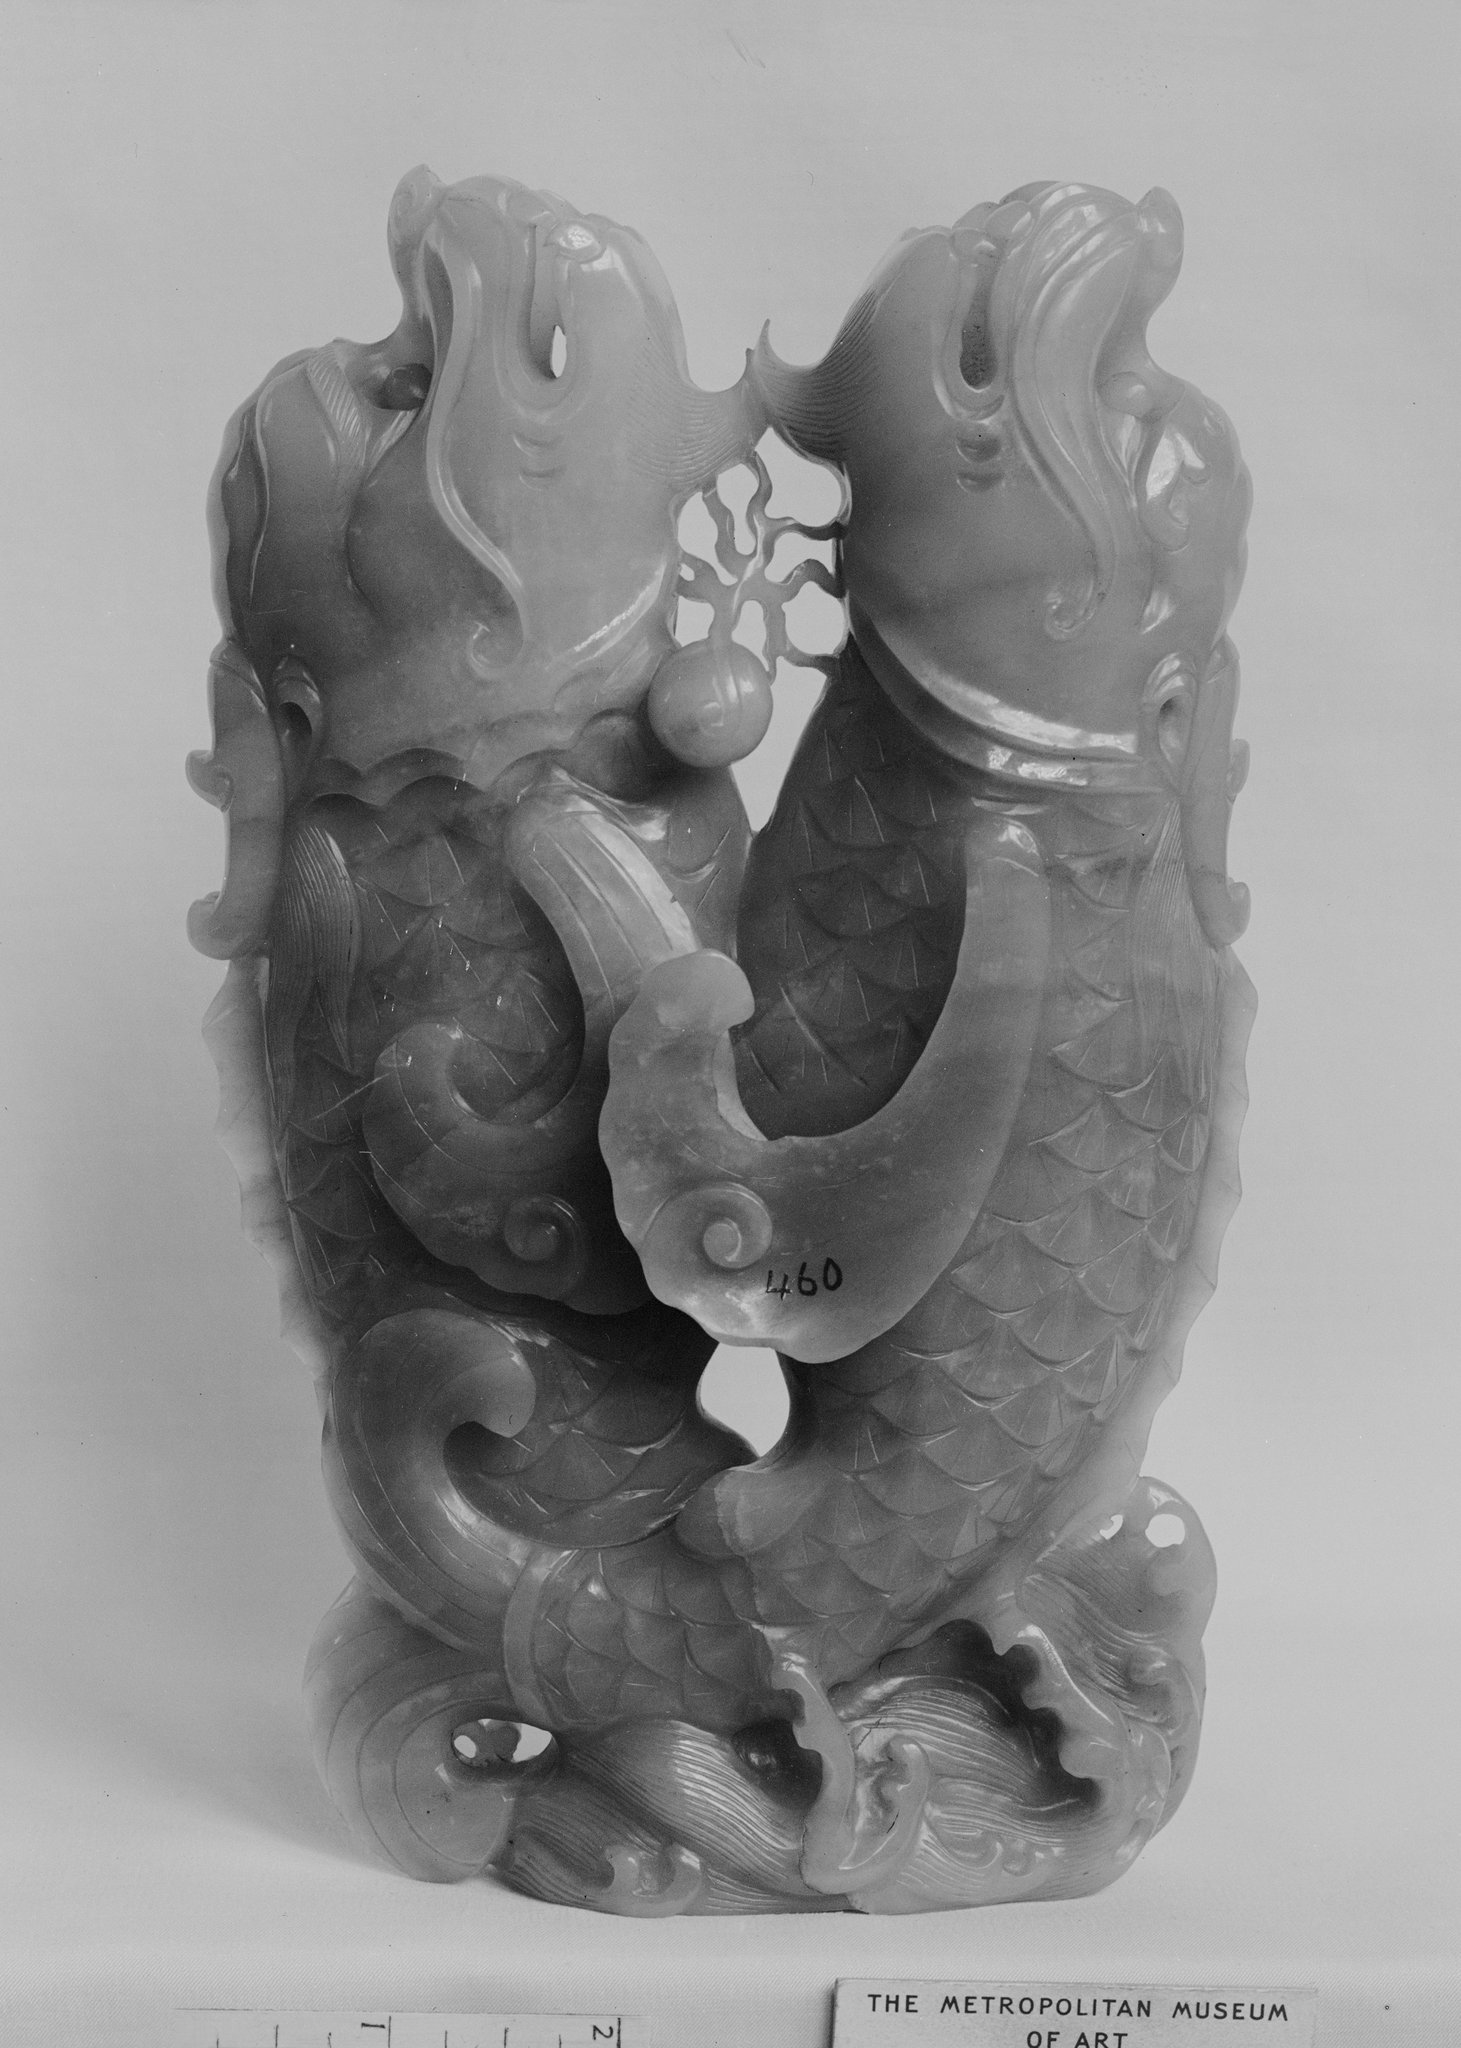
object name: vase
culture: chinese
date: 1662-1722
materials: down, jade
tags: fish